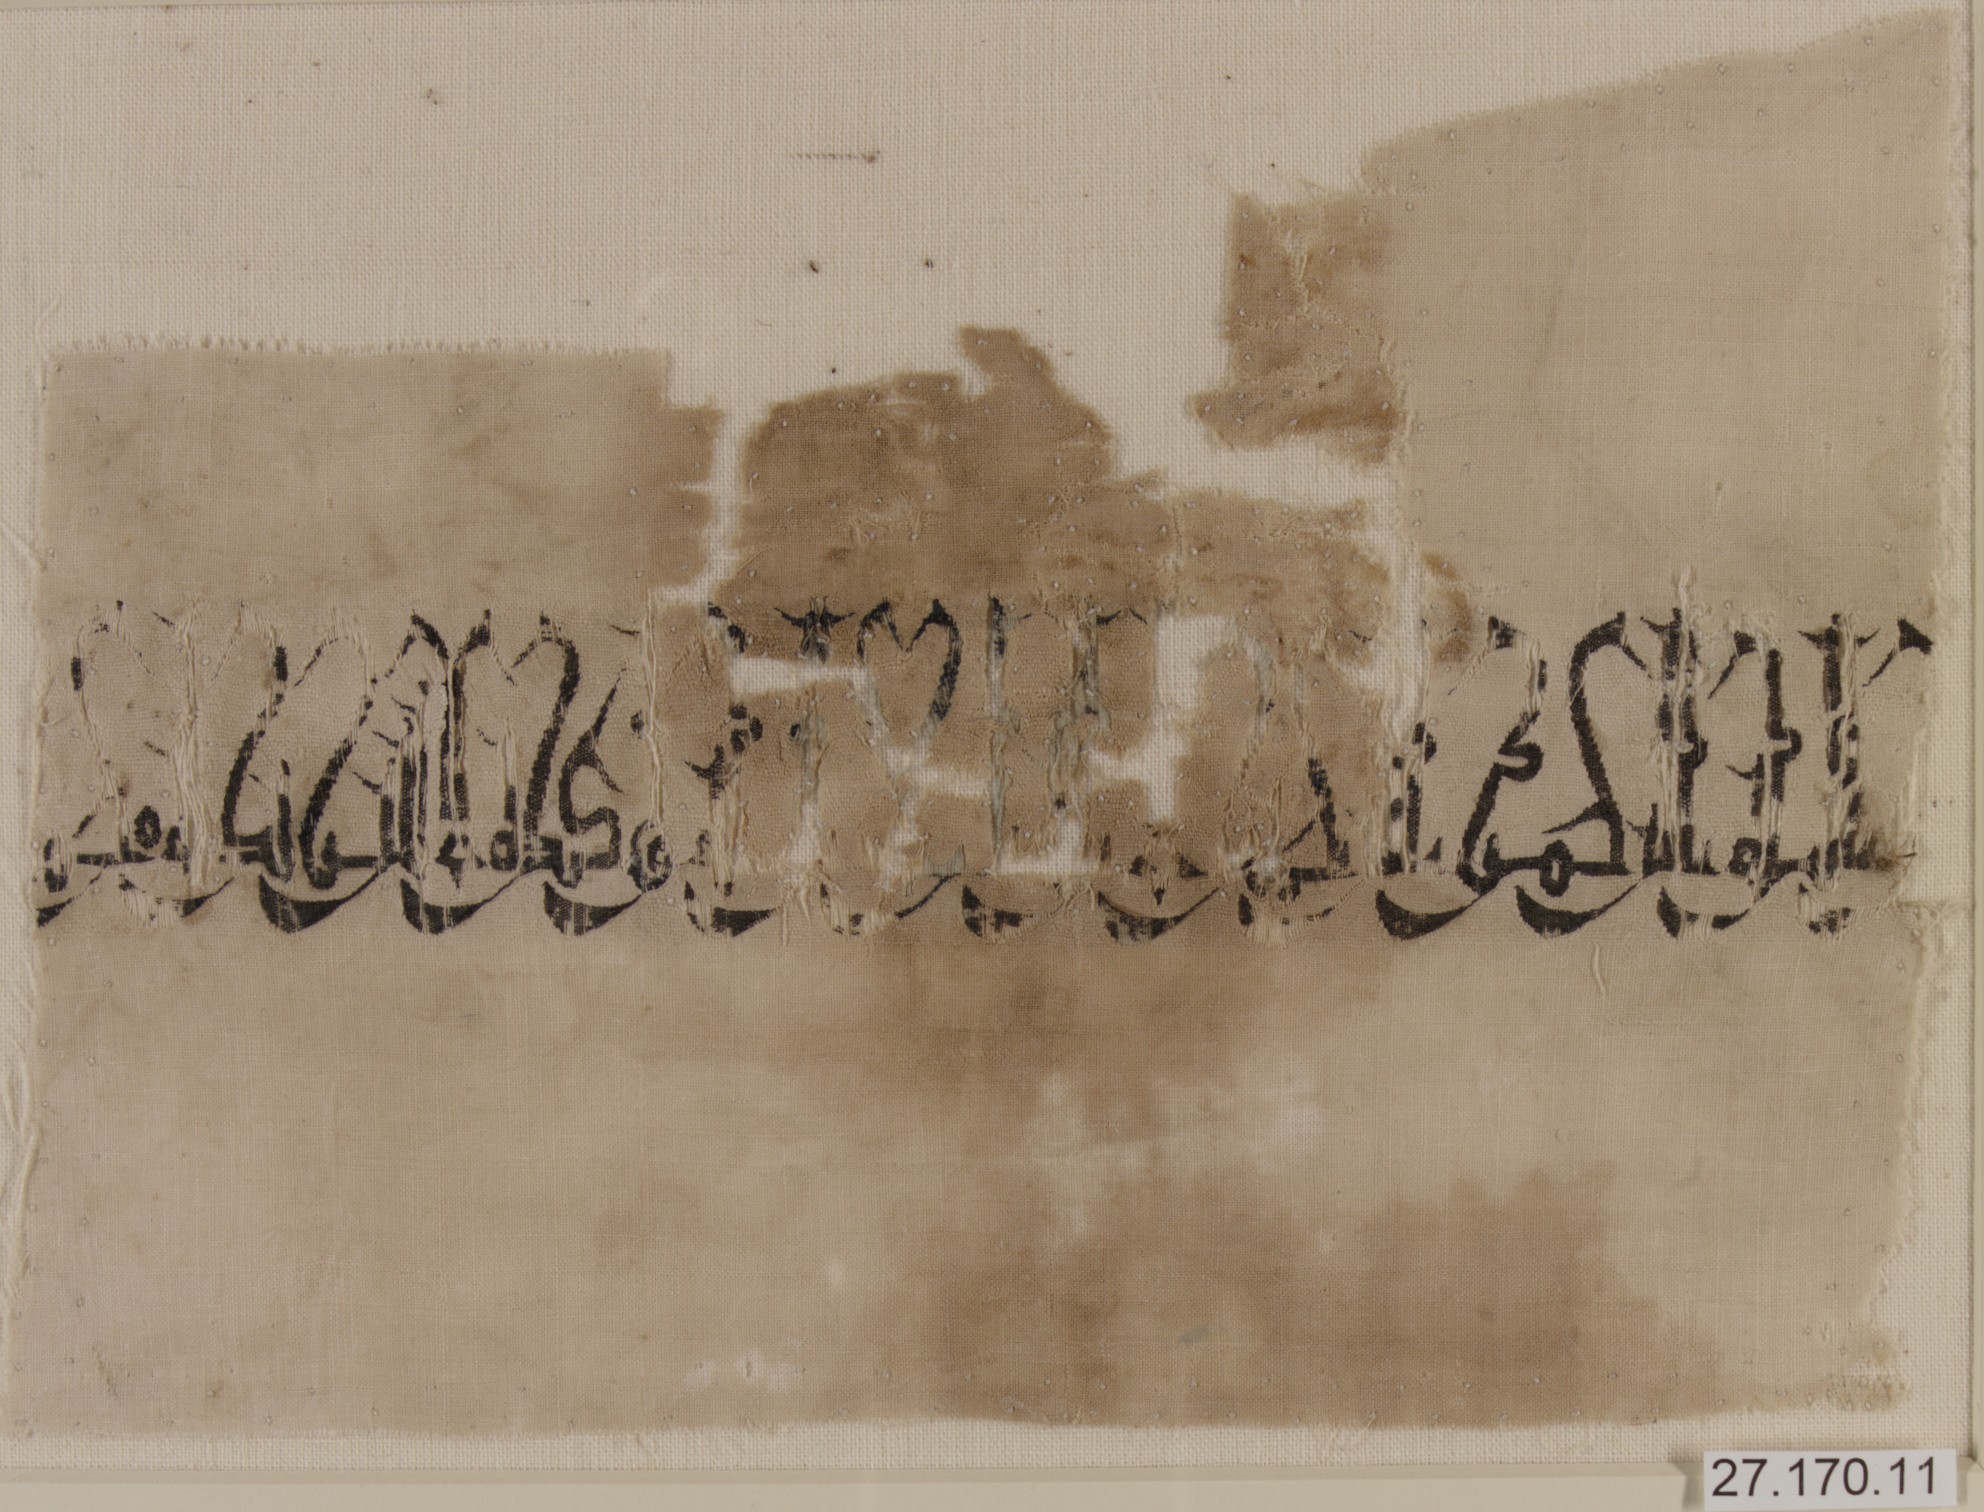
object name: textile fragment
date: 1067-1100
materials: linen, silk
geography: egypt